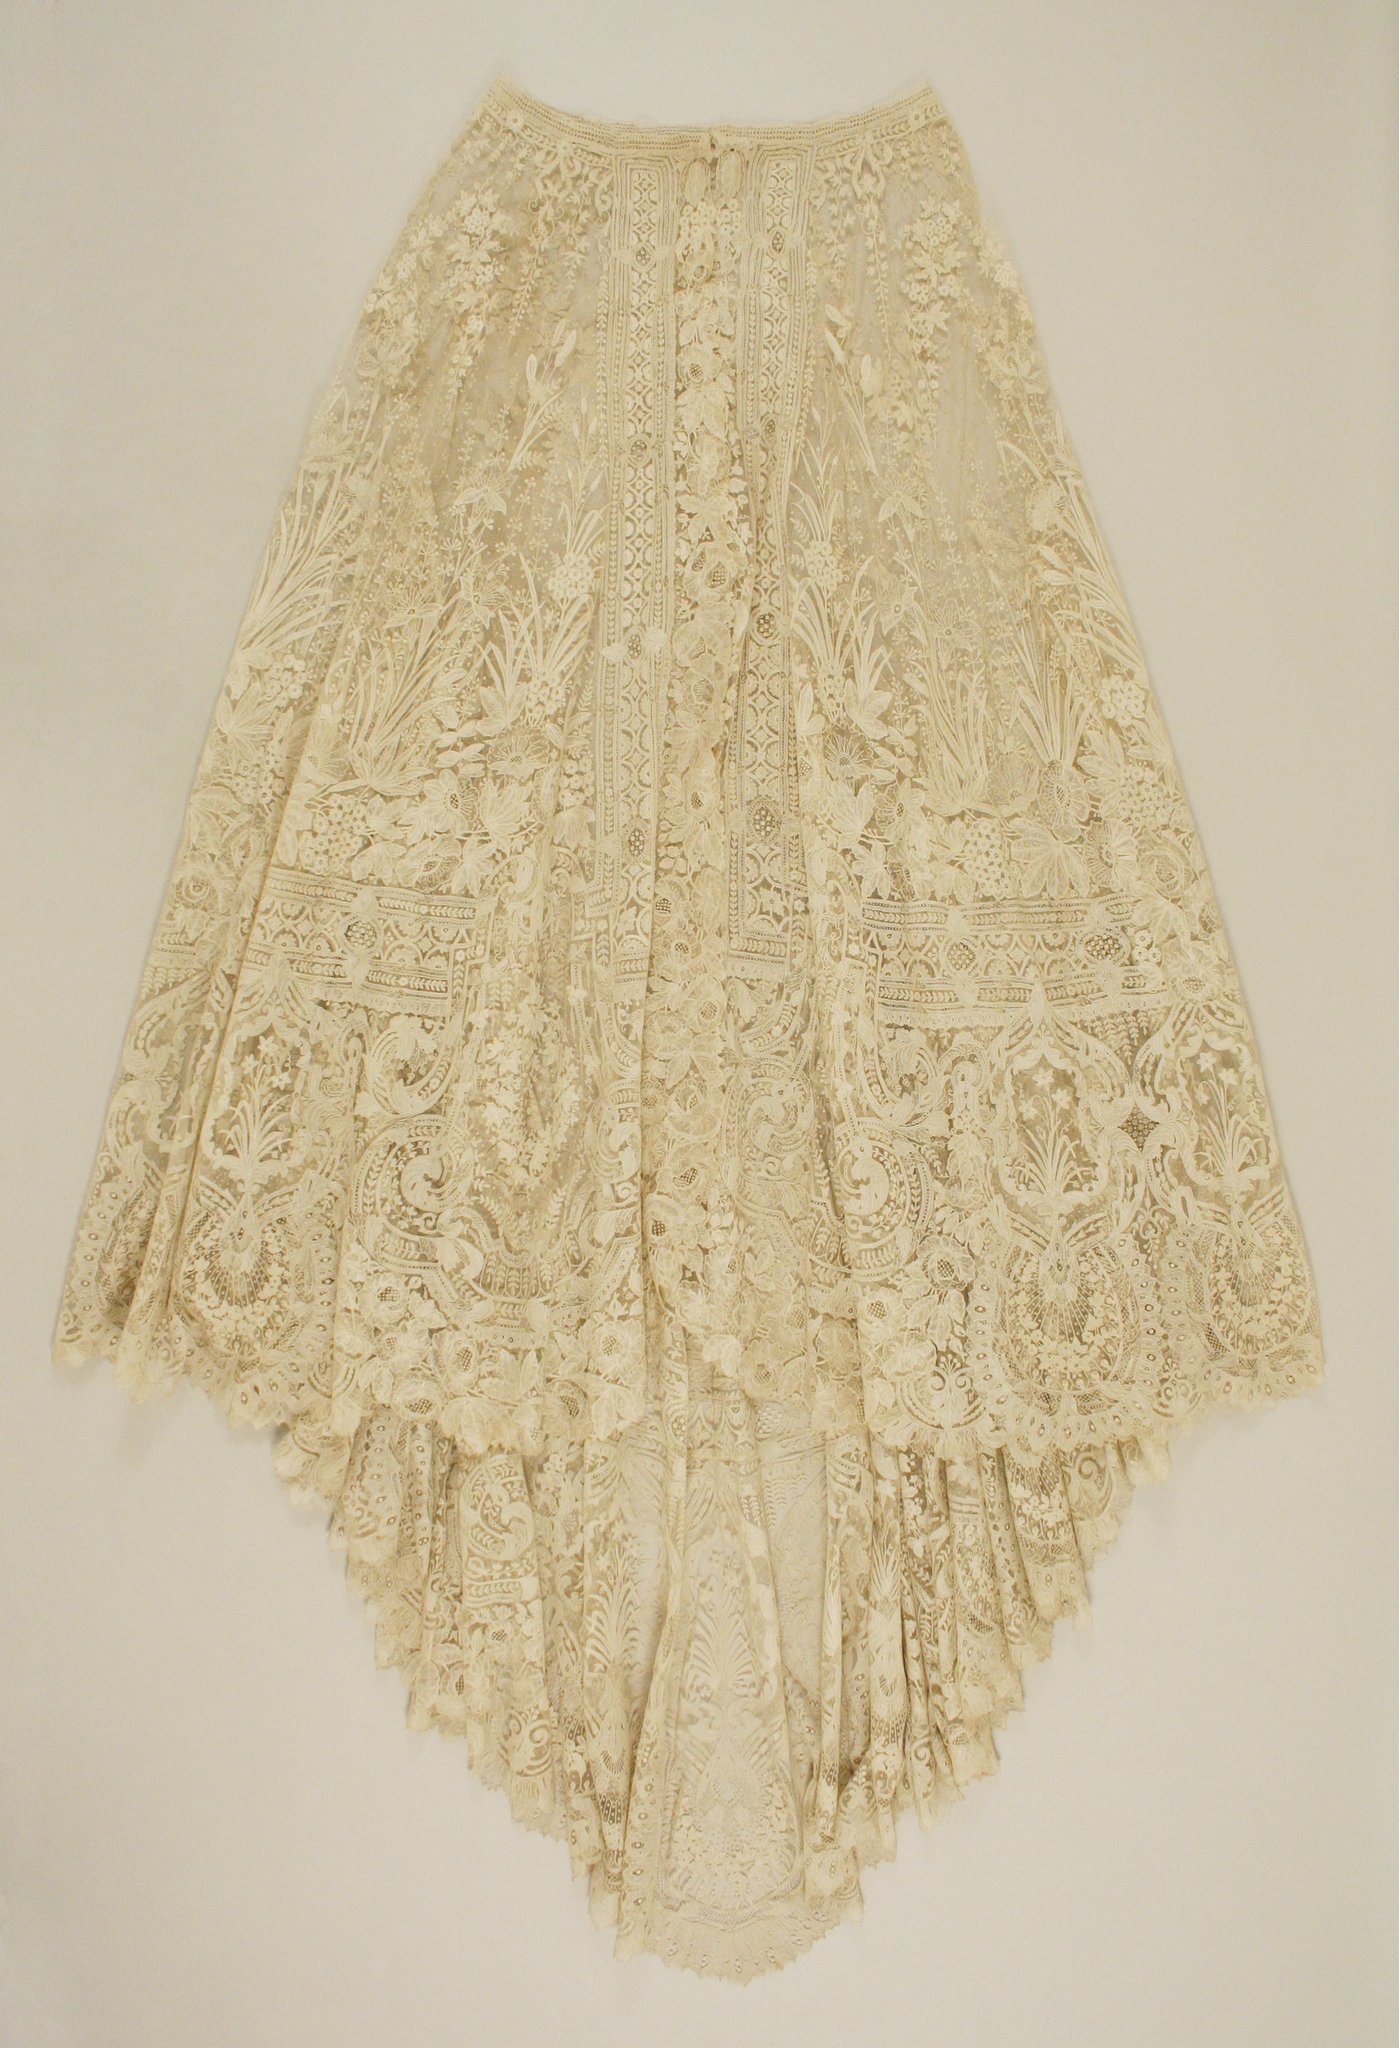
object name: skirt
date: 1867-1900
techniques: lace